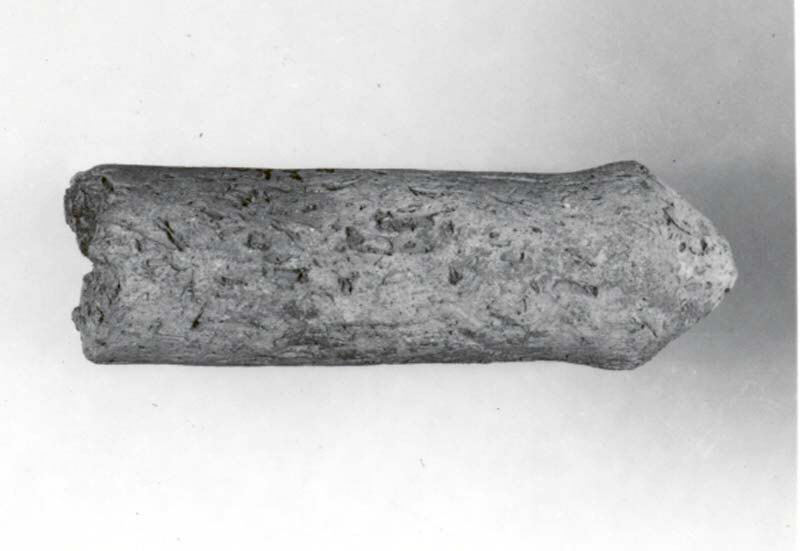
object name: phallus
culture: iranian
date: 4000-3500 BCE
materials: ceramic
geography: iran